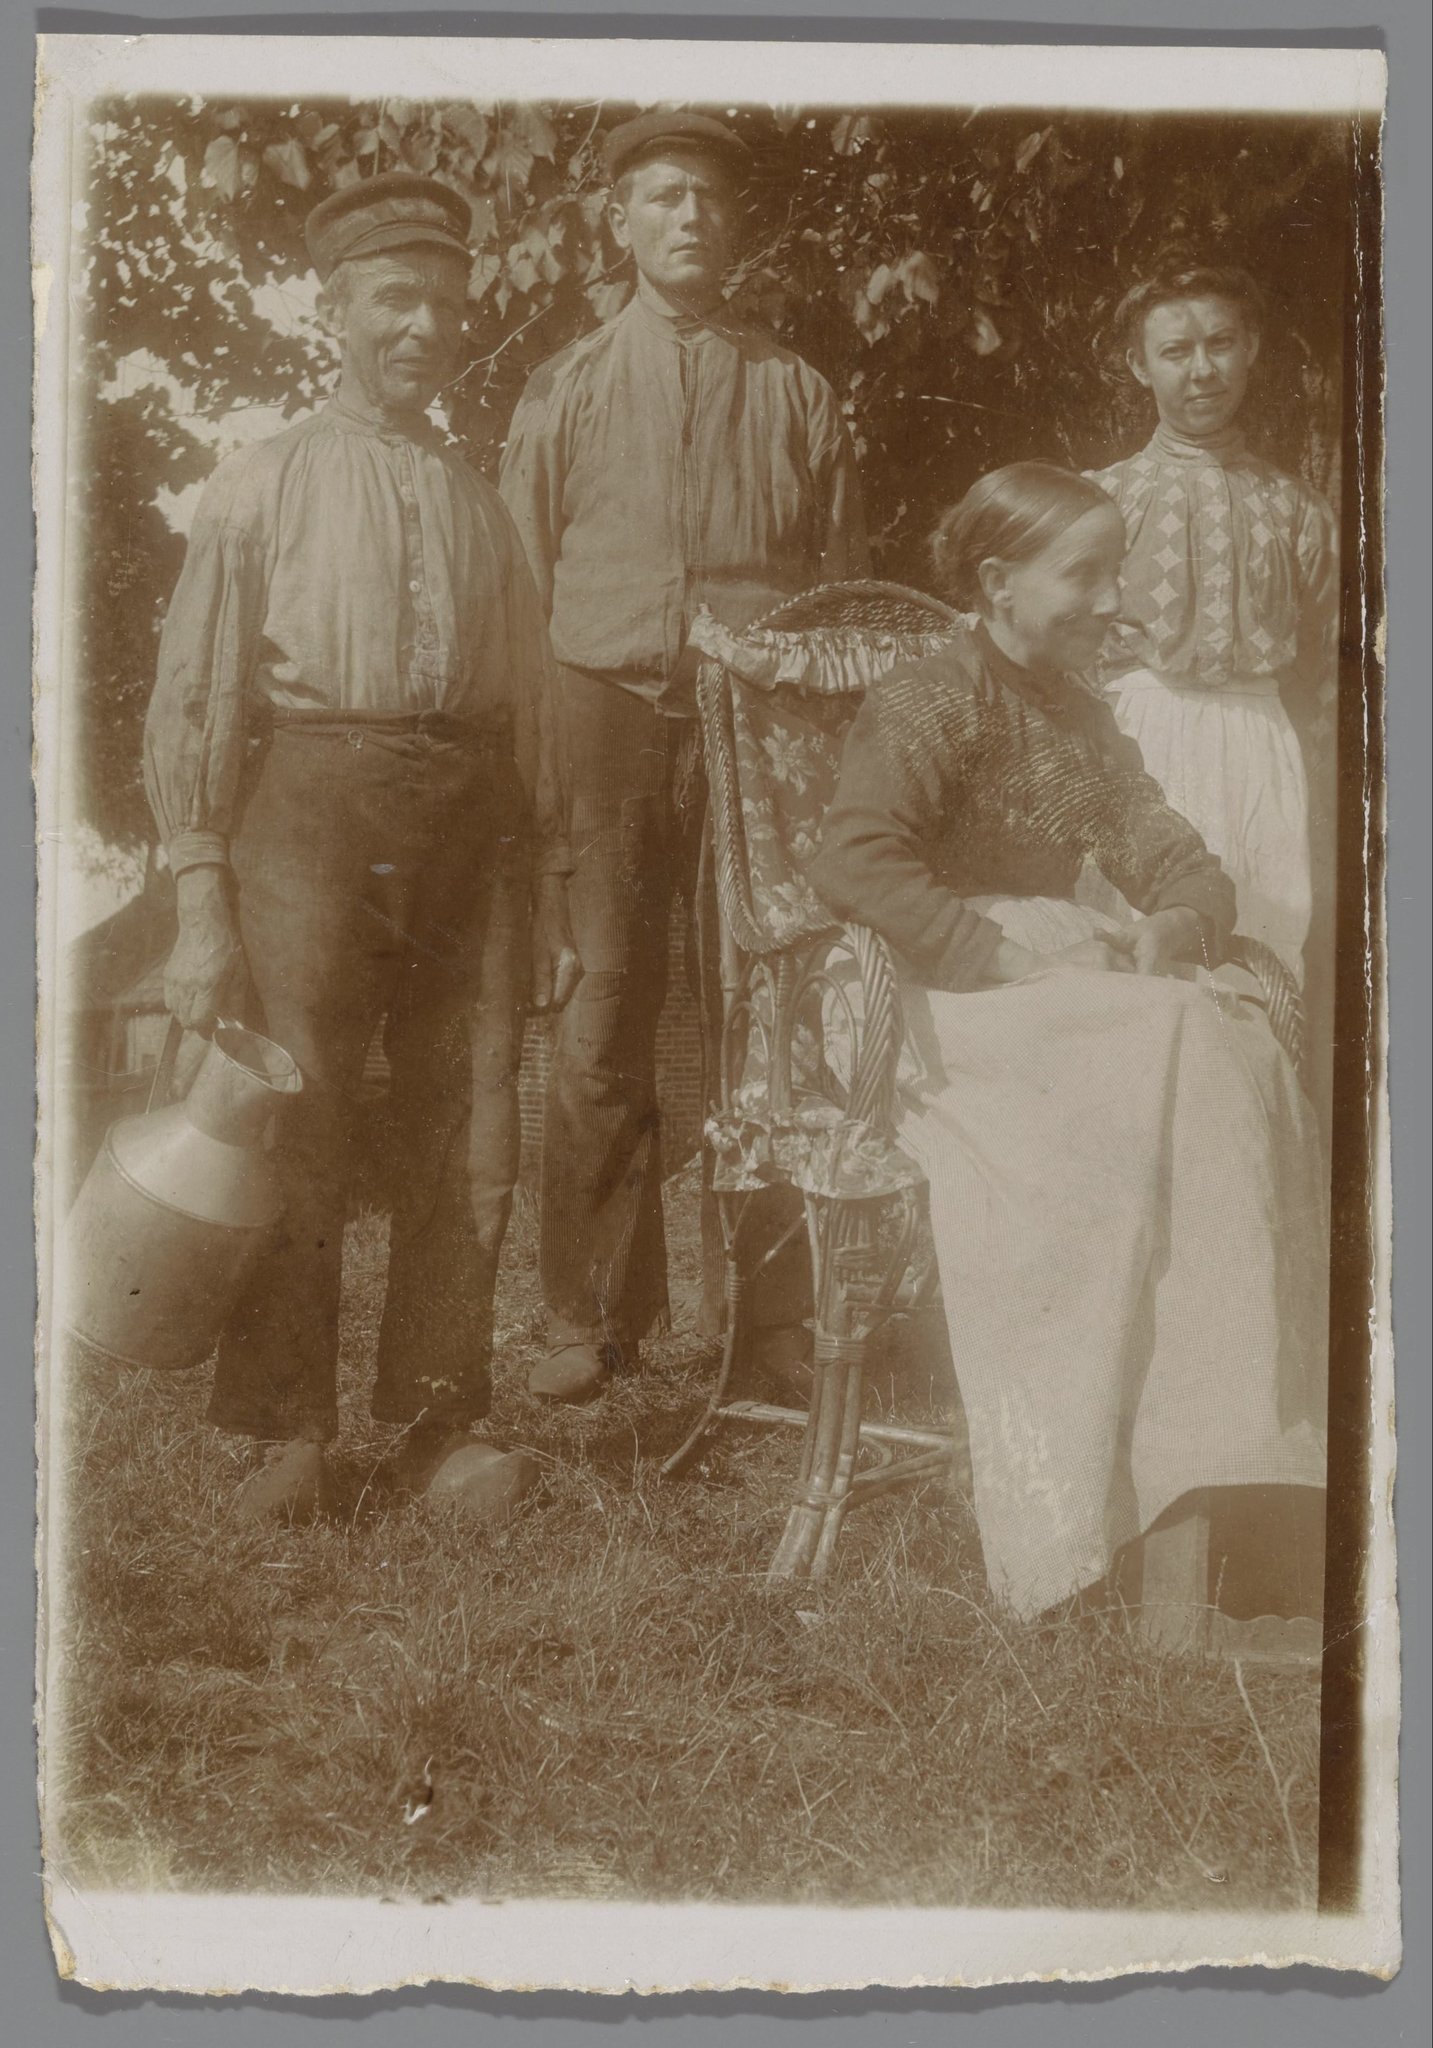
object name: photograph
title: Boerenfamilie in een tuin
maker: Anonymous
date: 1908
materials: paper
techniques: gelatin silver print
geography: netherlands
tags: family life